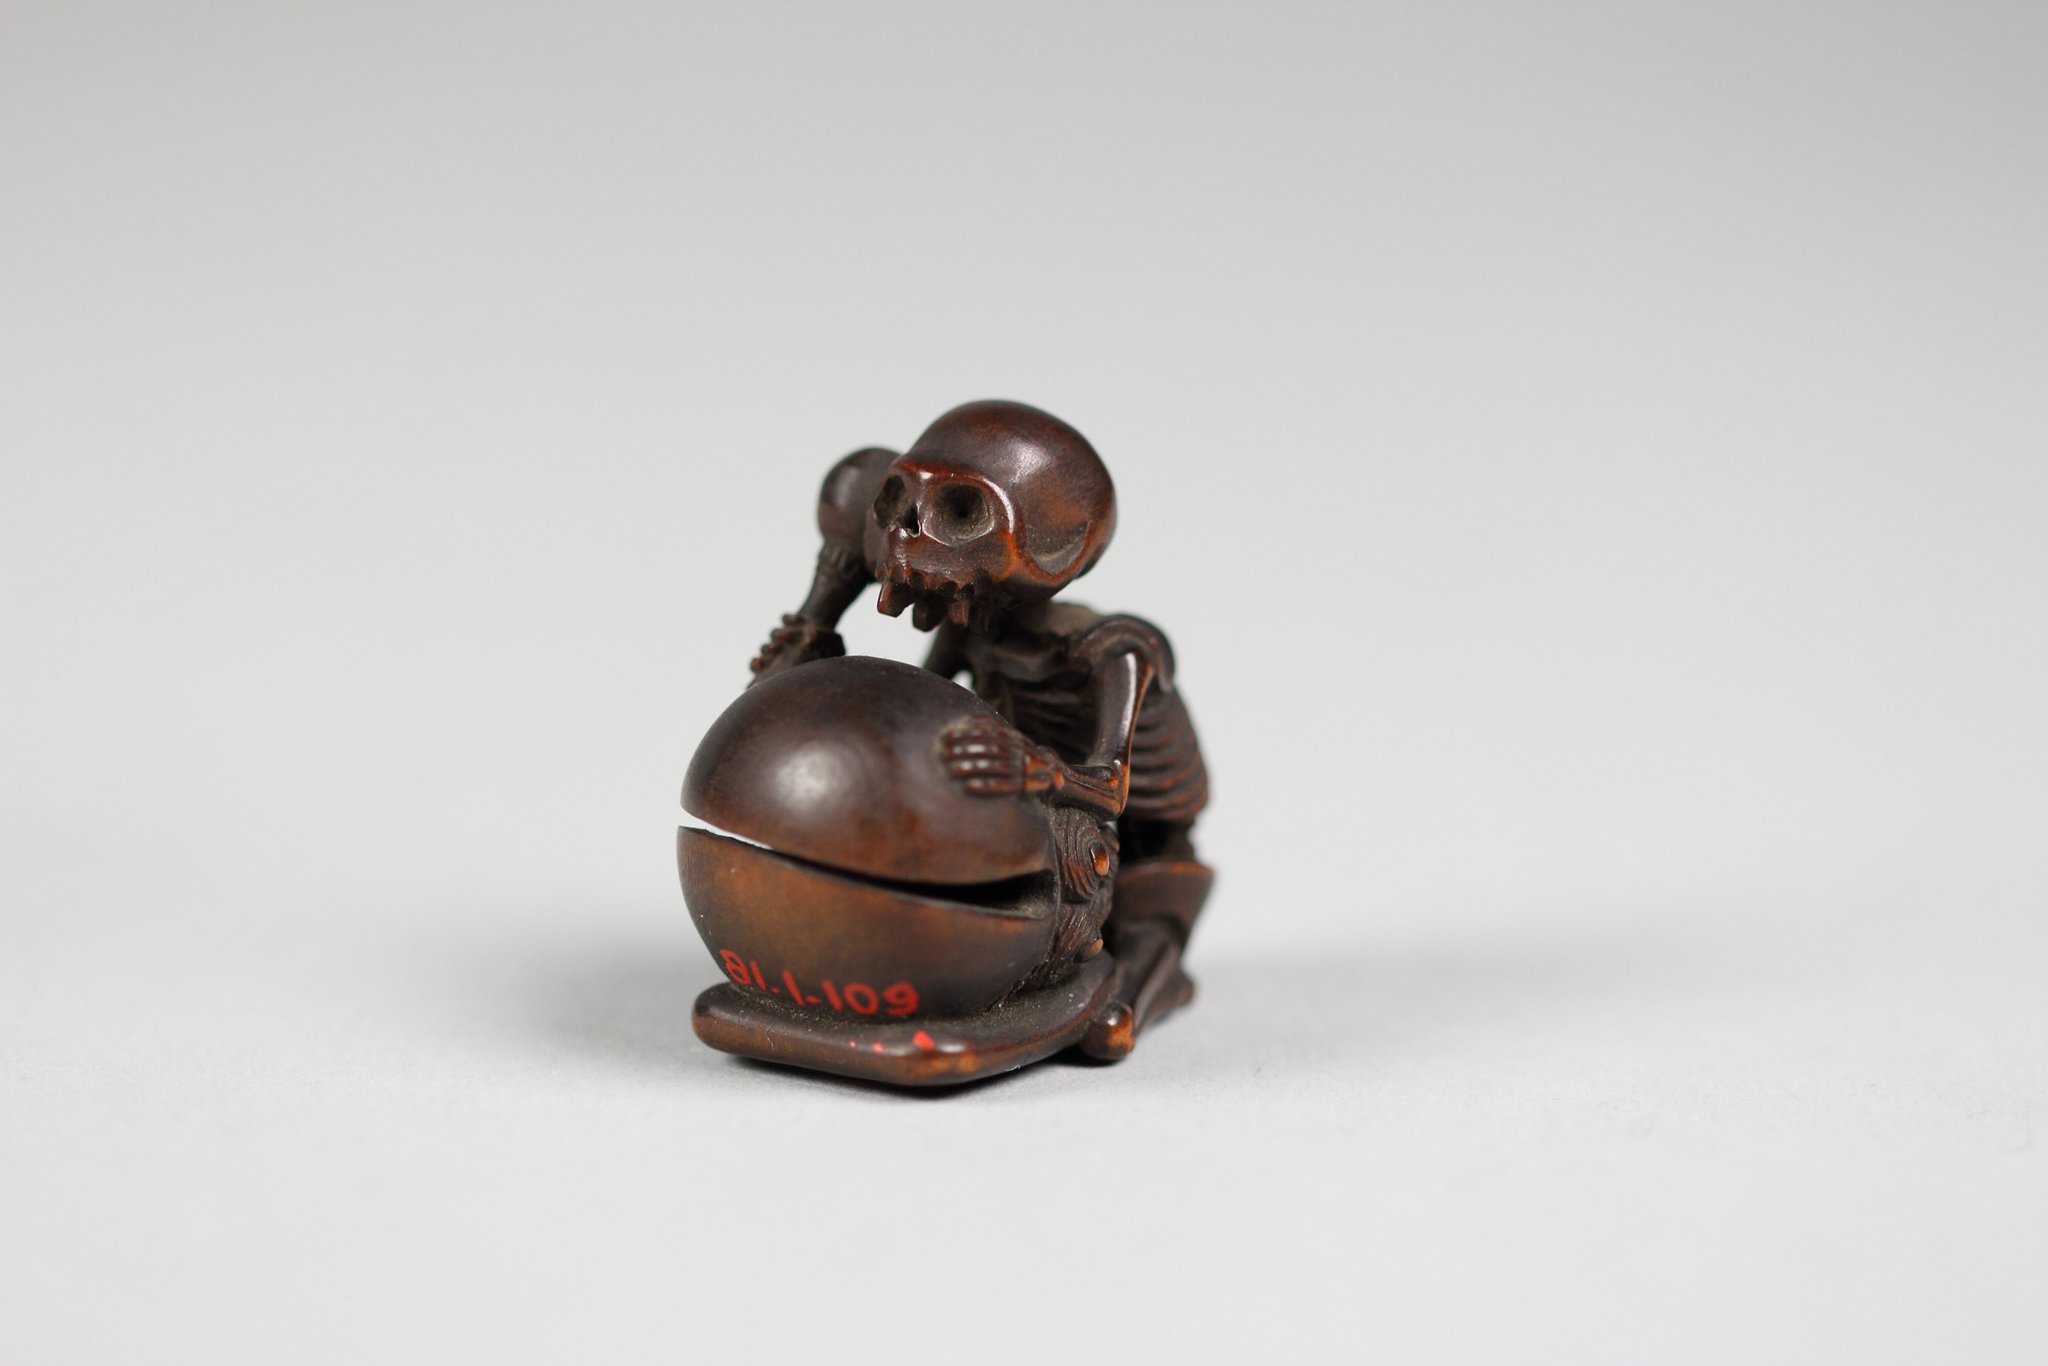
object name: netsuke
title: Skeleton beating a Drum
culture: japanese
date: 1701-1800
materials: wood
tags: skeletons,drums